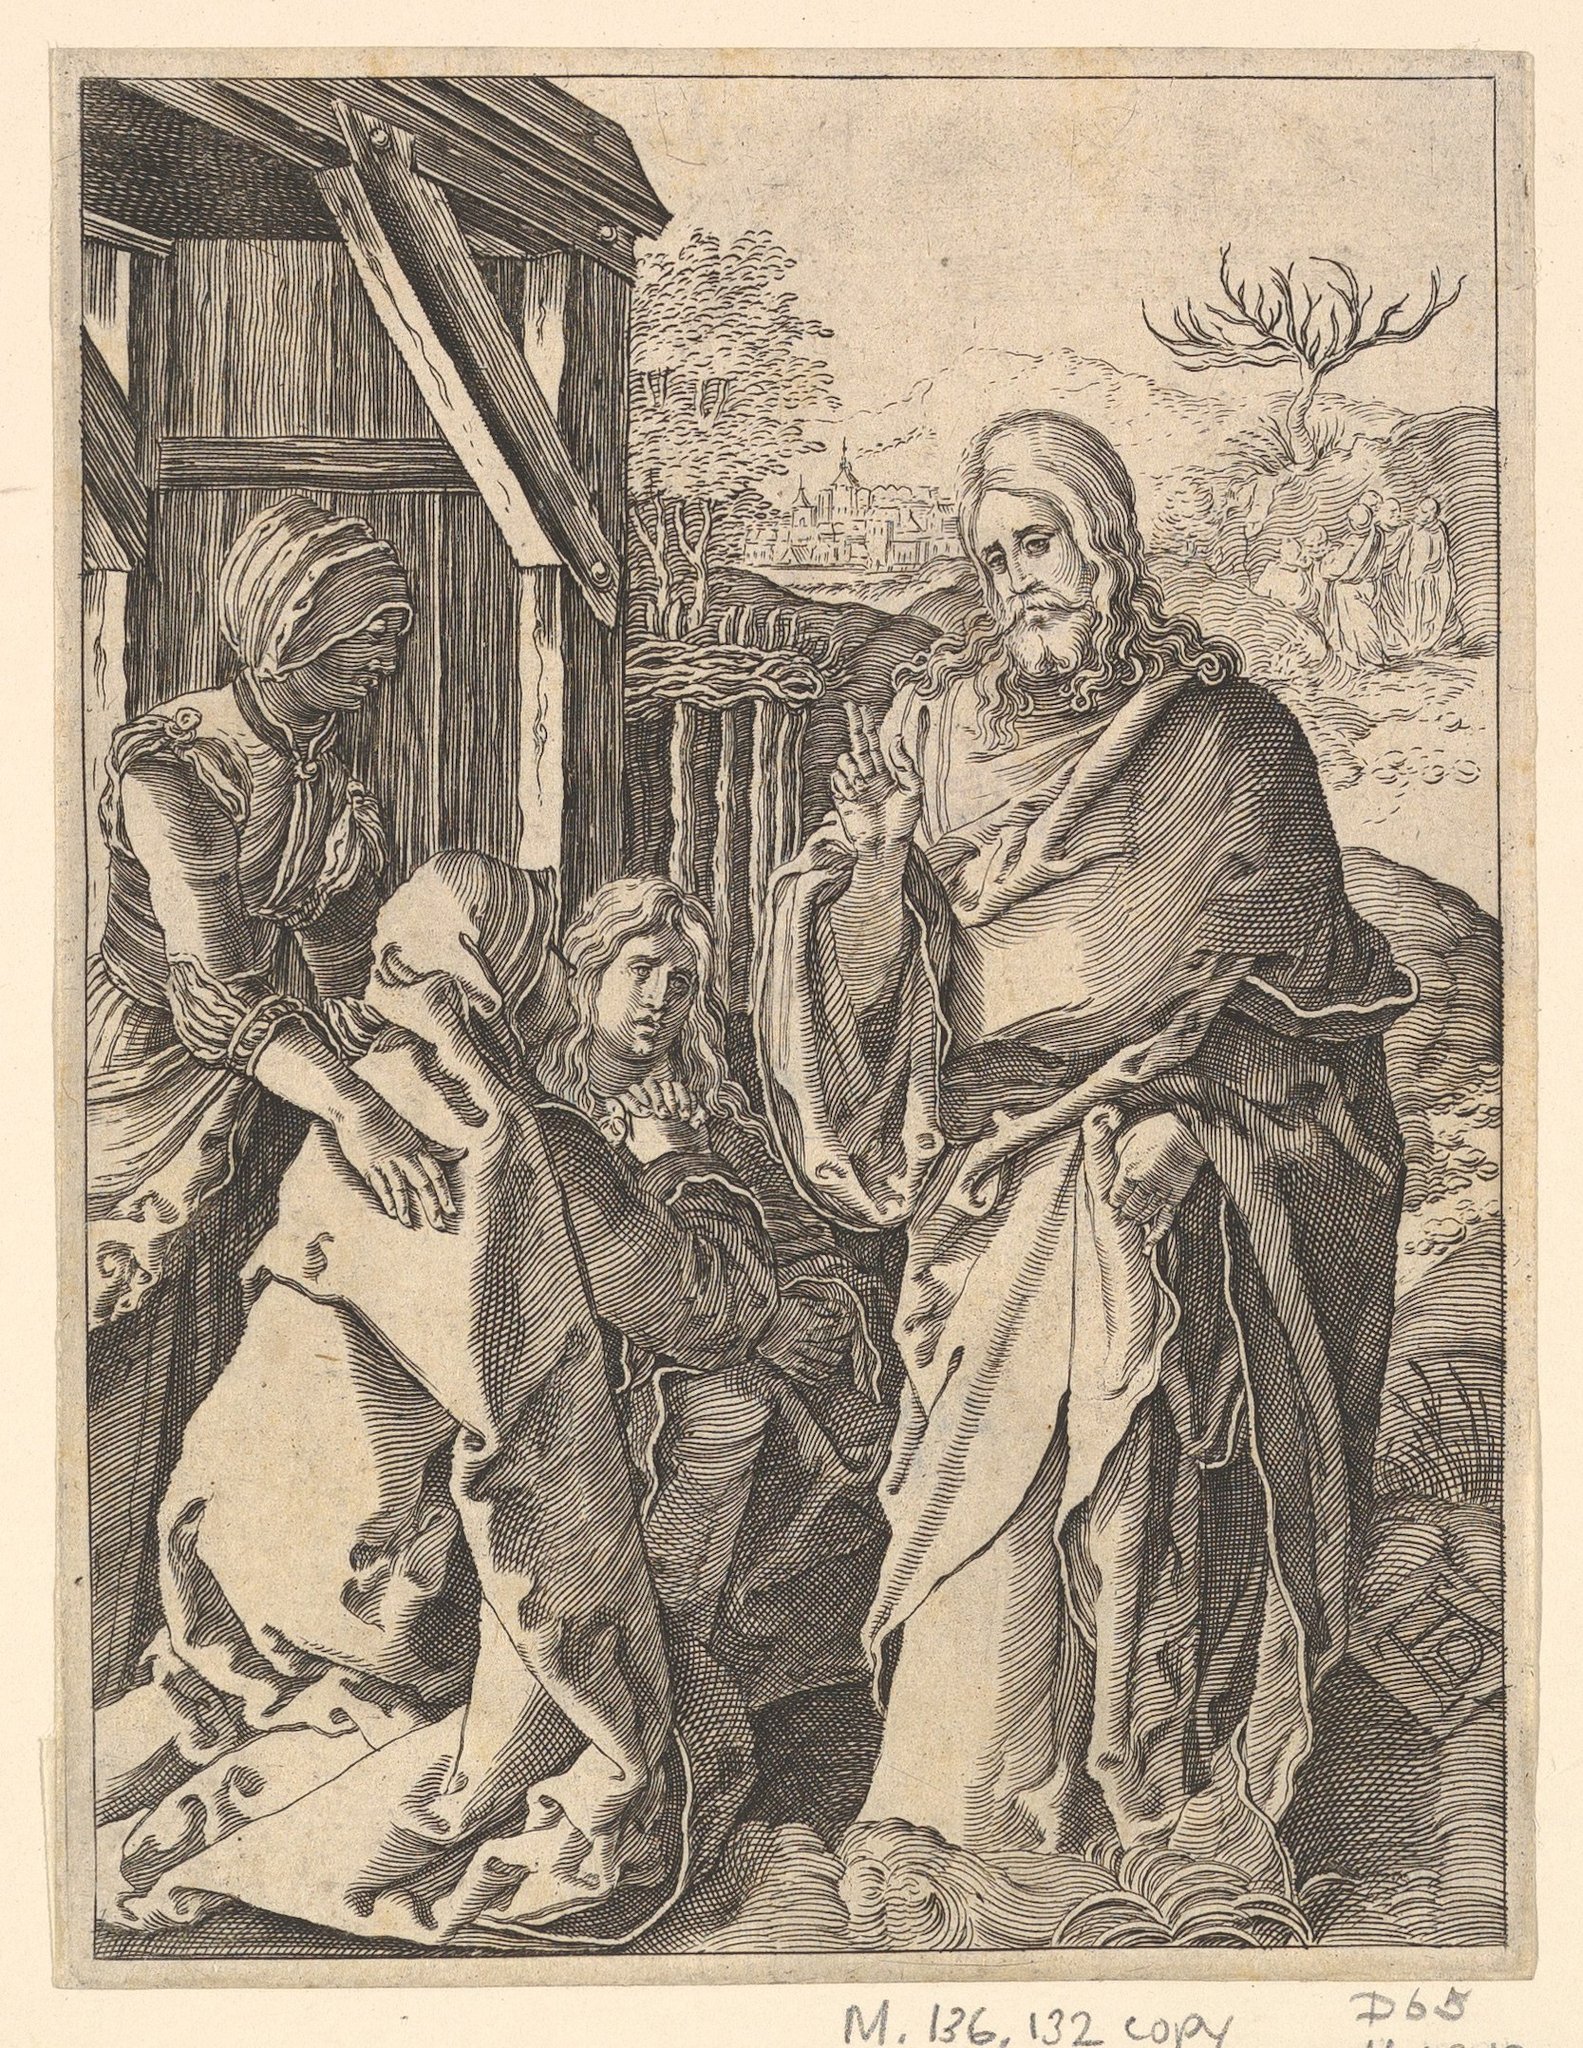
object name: print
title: Engraved copies of The Little Passion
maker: albrecht dürer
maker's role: artist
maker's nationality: german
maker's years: 1471-1528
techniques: engraving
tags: men,women,jesus